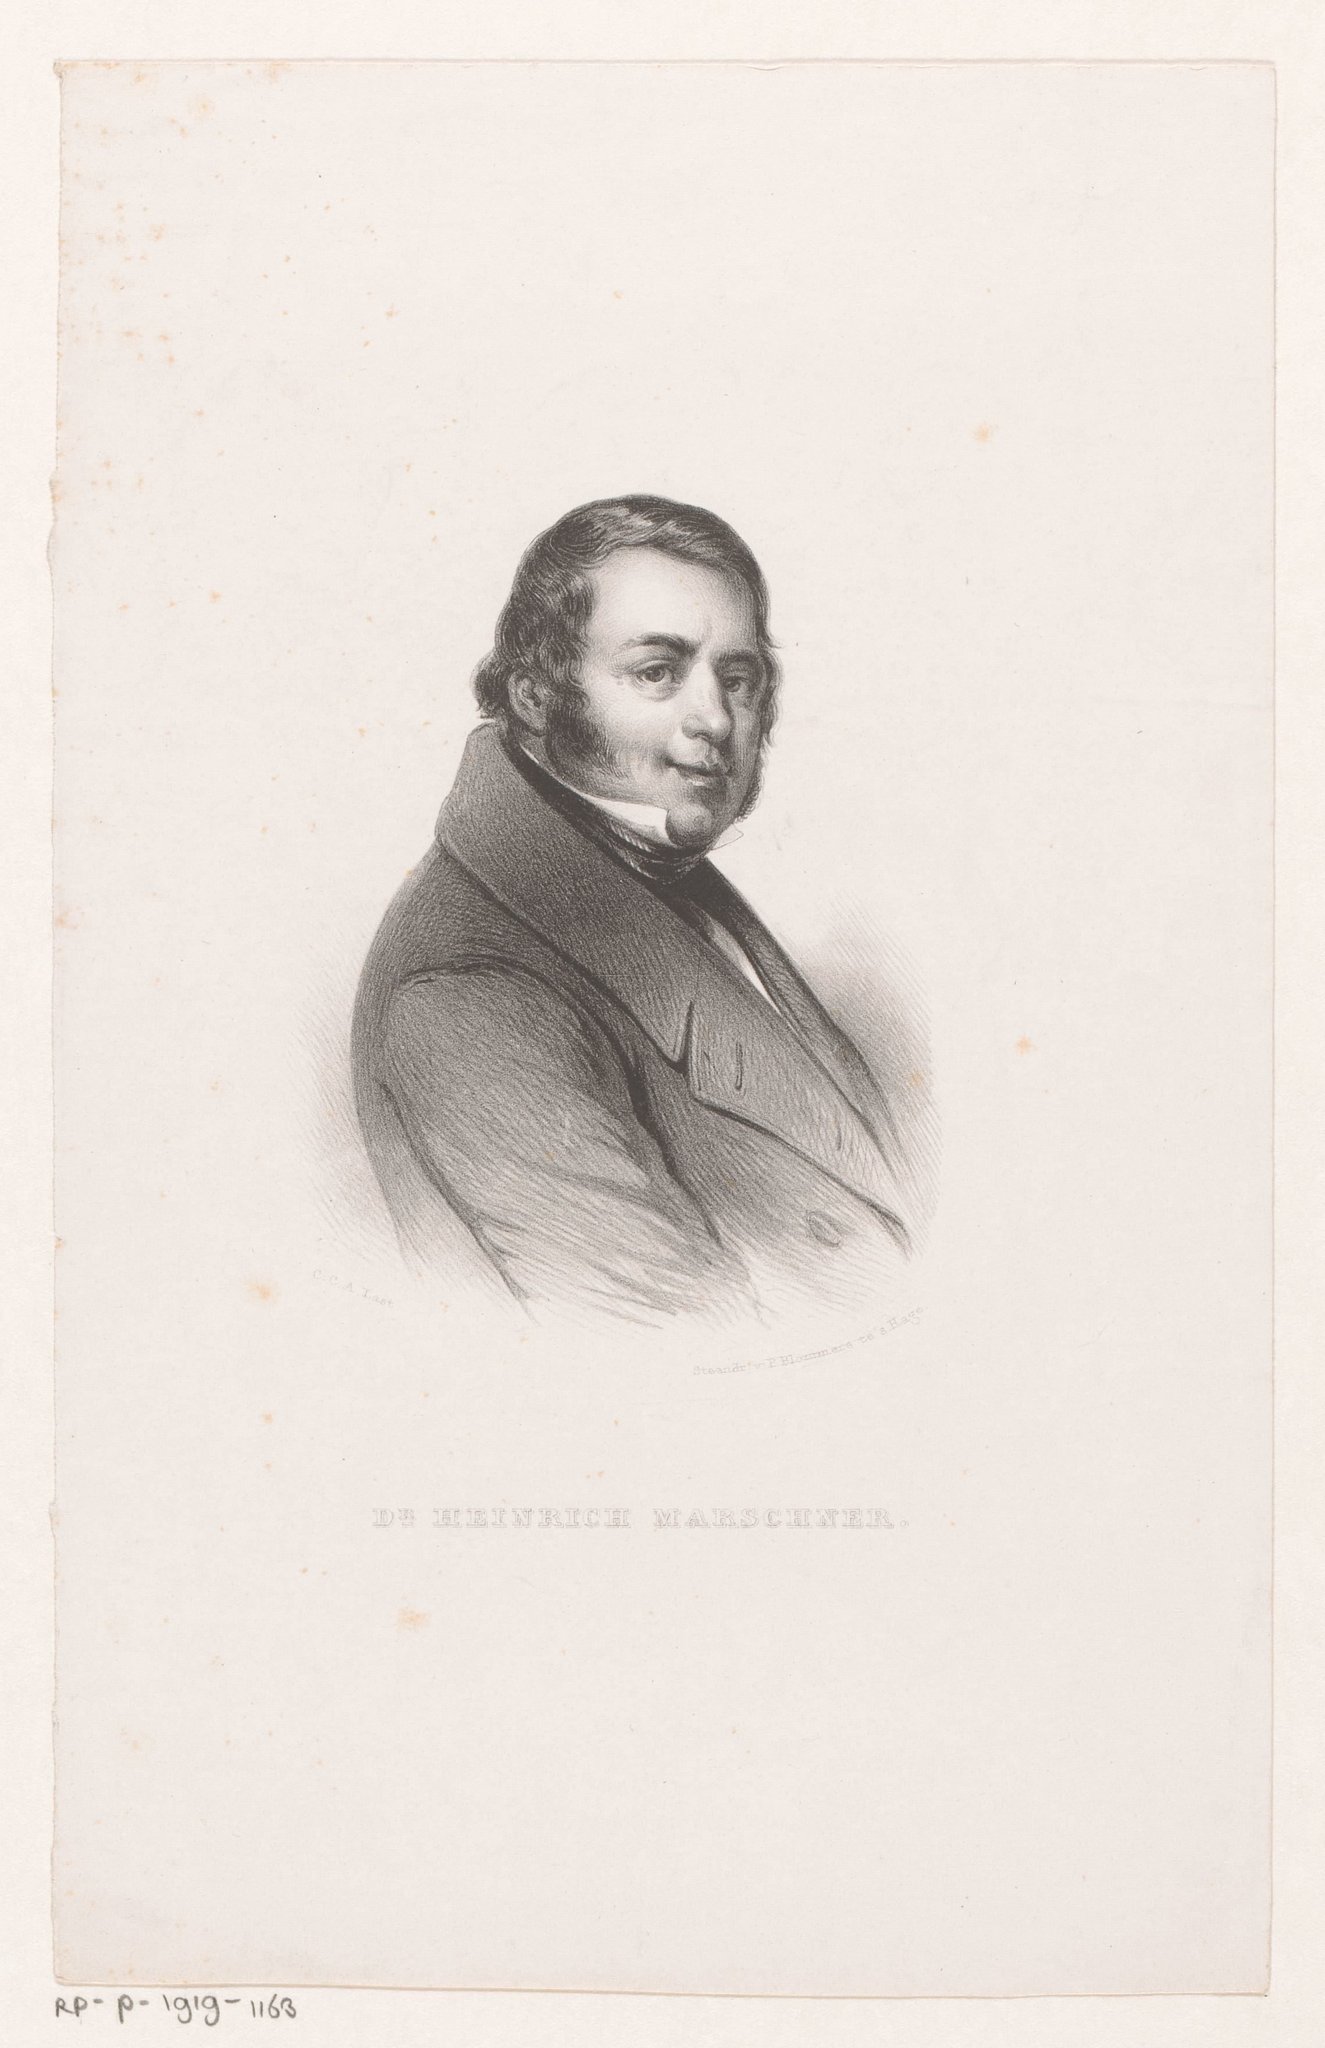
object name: print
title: Portret van Heinrich Marschner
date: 1842-1887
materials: paper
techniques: lithograph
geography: the hague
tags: historical persons (+ (full) bust portrait)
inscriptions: collector's mark: Lugt 2228